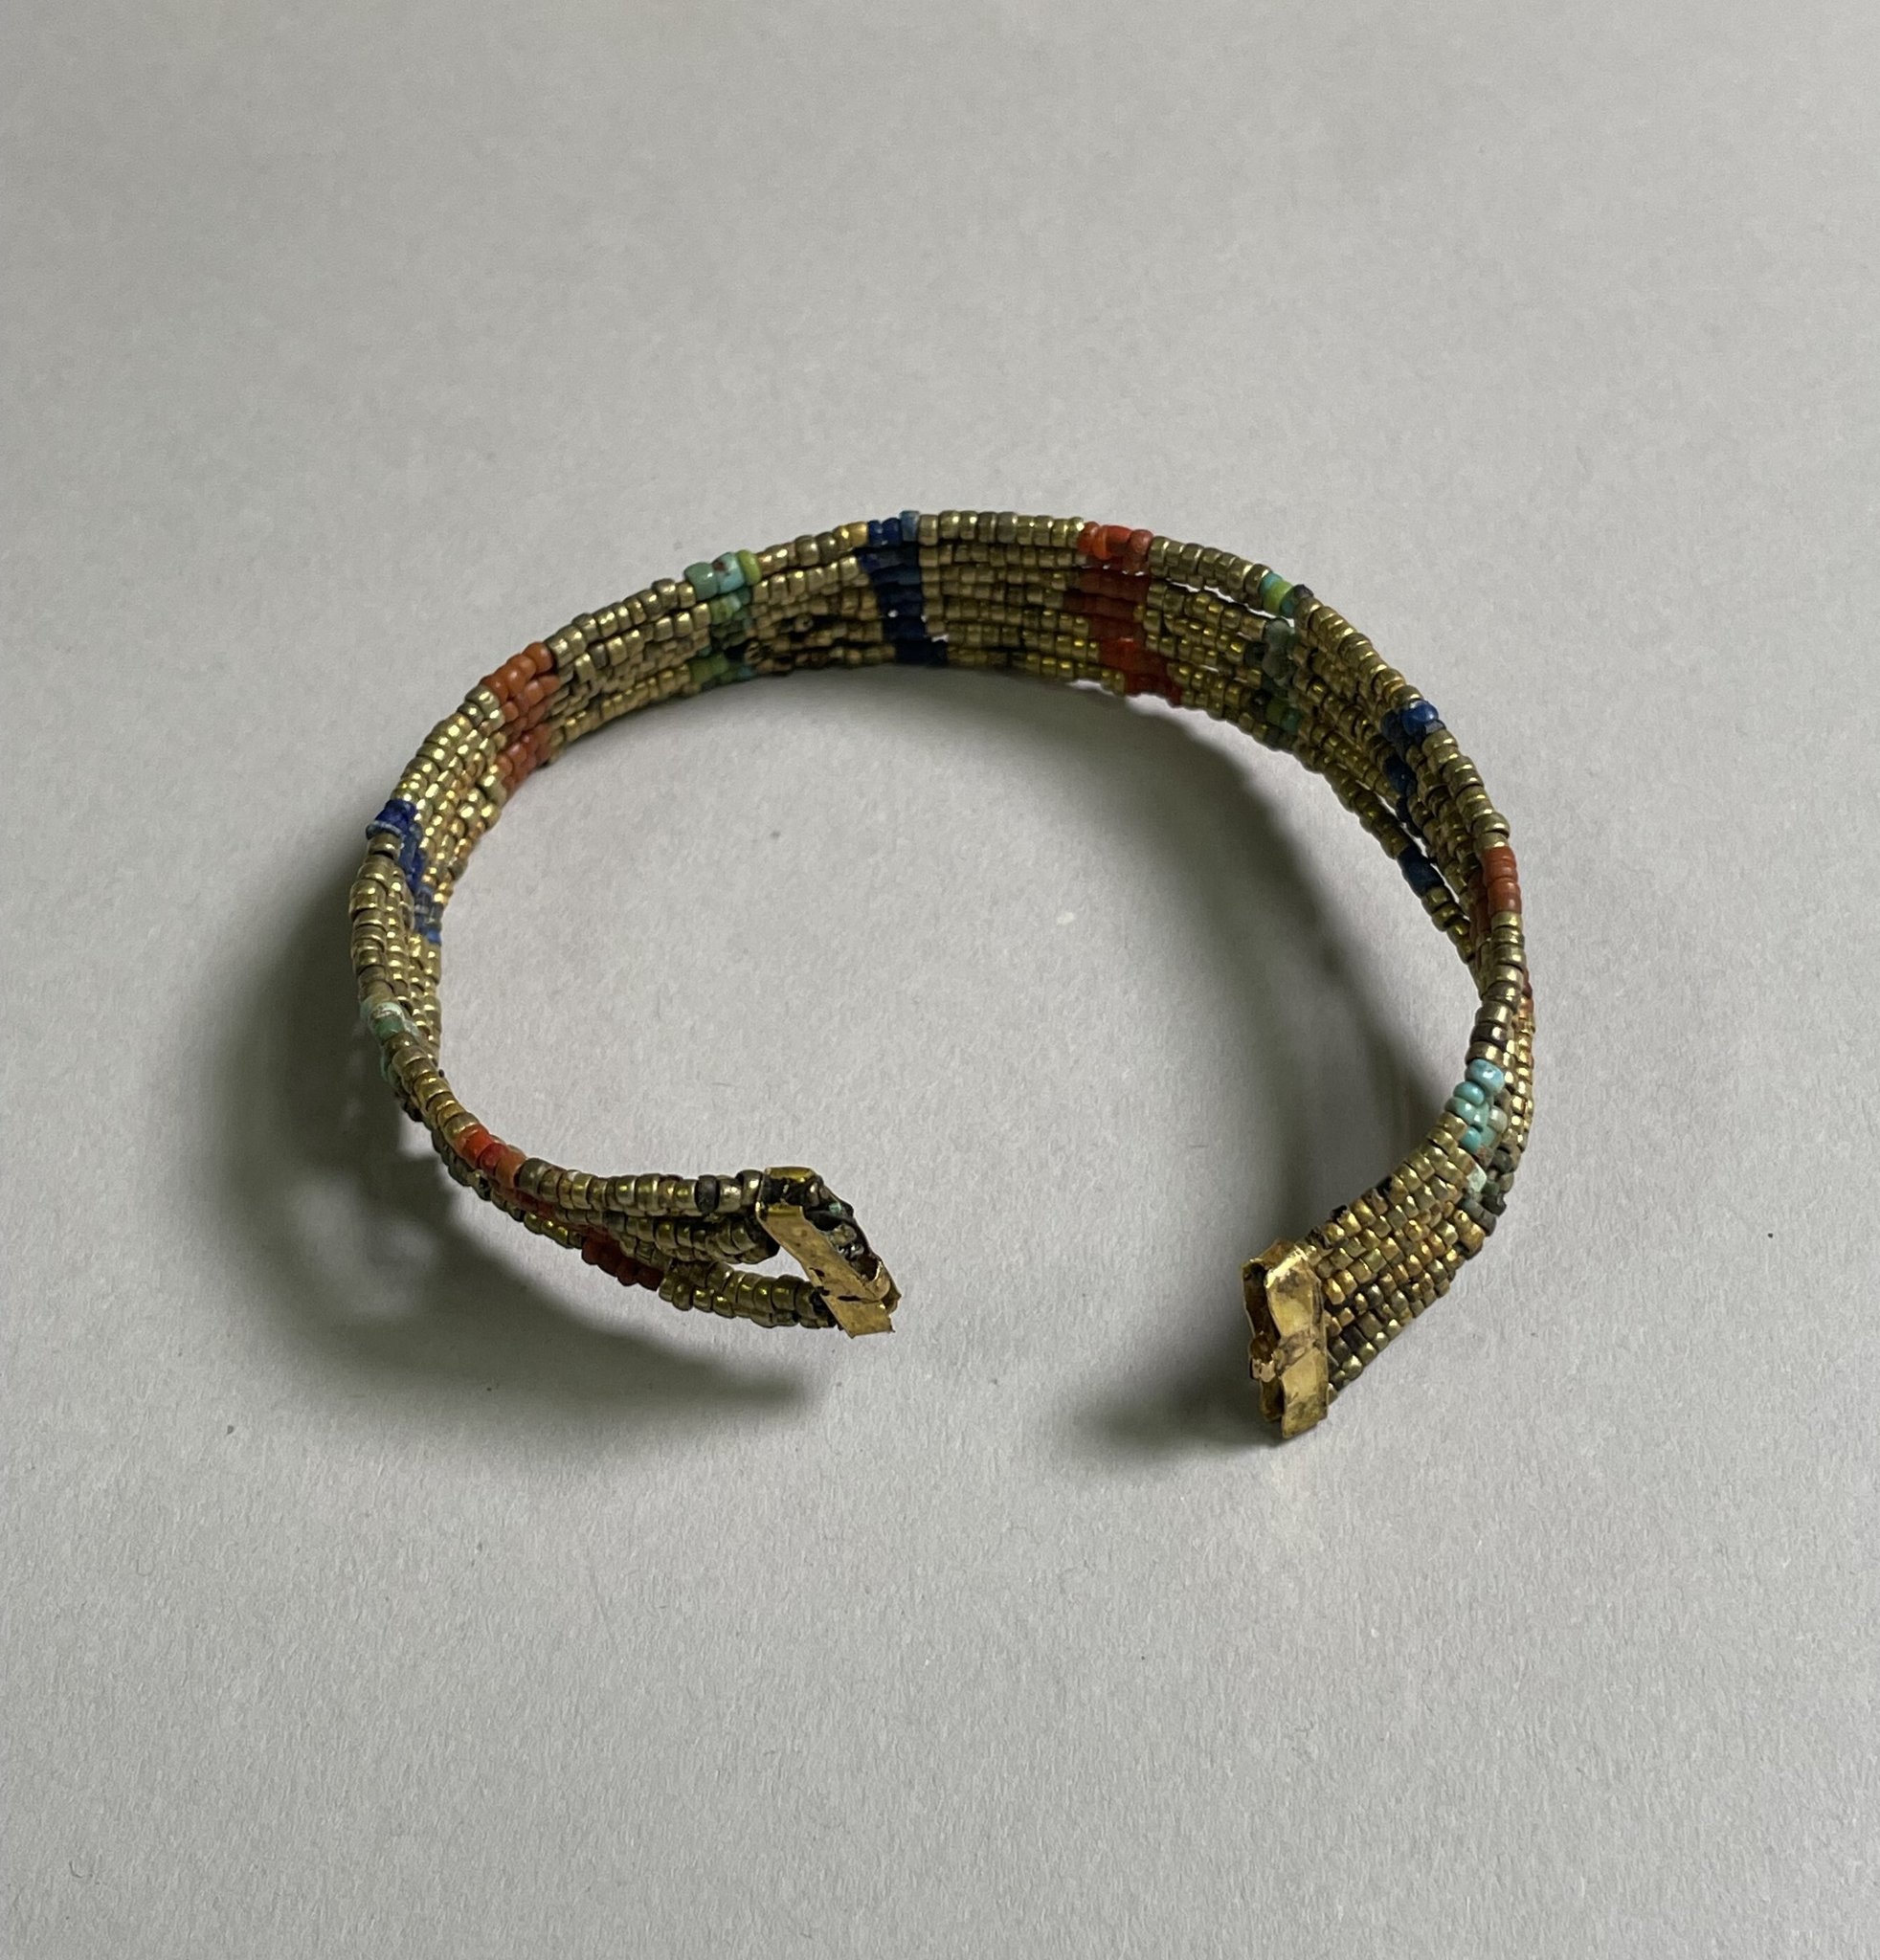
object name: armlet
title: Beaded Armlet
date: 1550-1525 BCE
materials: bronze, gemstone, copper, faience, glass, gold, lapis lazuli, metal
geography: egypt